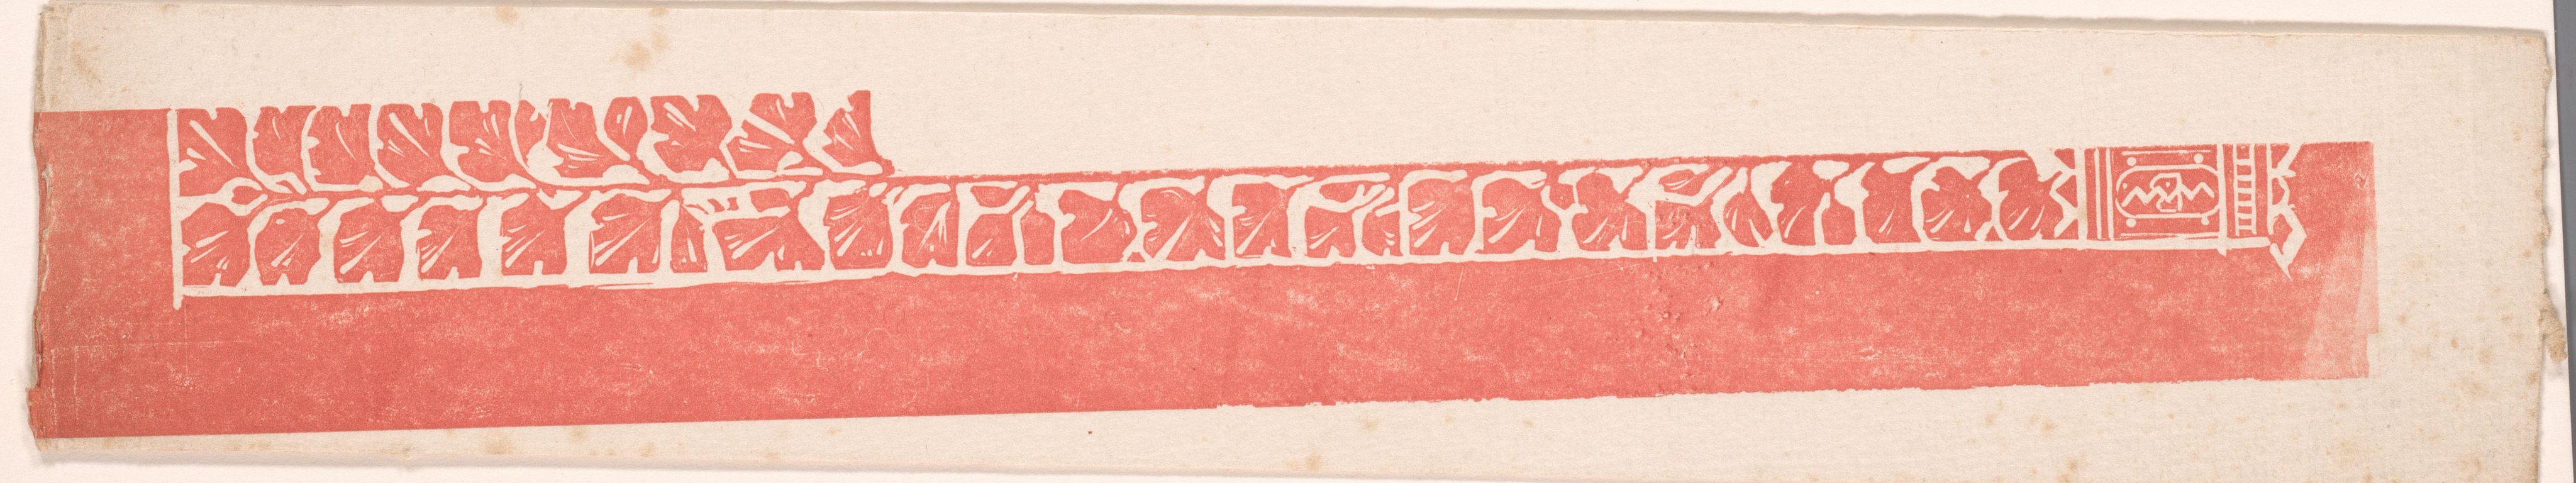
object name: print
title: Ornament met bladeren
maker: bernard willem wierink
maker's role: draughtsman, print maker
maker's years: 1856-1939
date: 1910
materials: paper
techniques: relief print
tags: fable of reynard the fox, foliage, tendrils, branches ~ ornament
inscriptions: collector's mark: Lugt 2228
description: Ontwerp voor: Streuvels, Stijn (Frank Lateur). Reinaert de Vos naar verschillende uitgaven van het middeleeuwsche epos. Amsterdam: L.J. Veen, 1910. Deze prent is vermoedelijk een plaatsnede, ook al wordt in de literatuur veelal gesproken over een houtsnede. Voor zover Wierink zijn prenten in hoogdruk zelf nader heeft omschreven, heeft hij altijd de term 'plaatsnede' gebruikt.